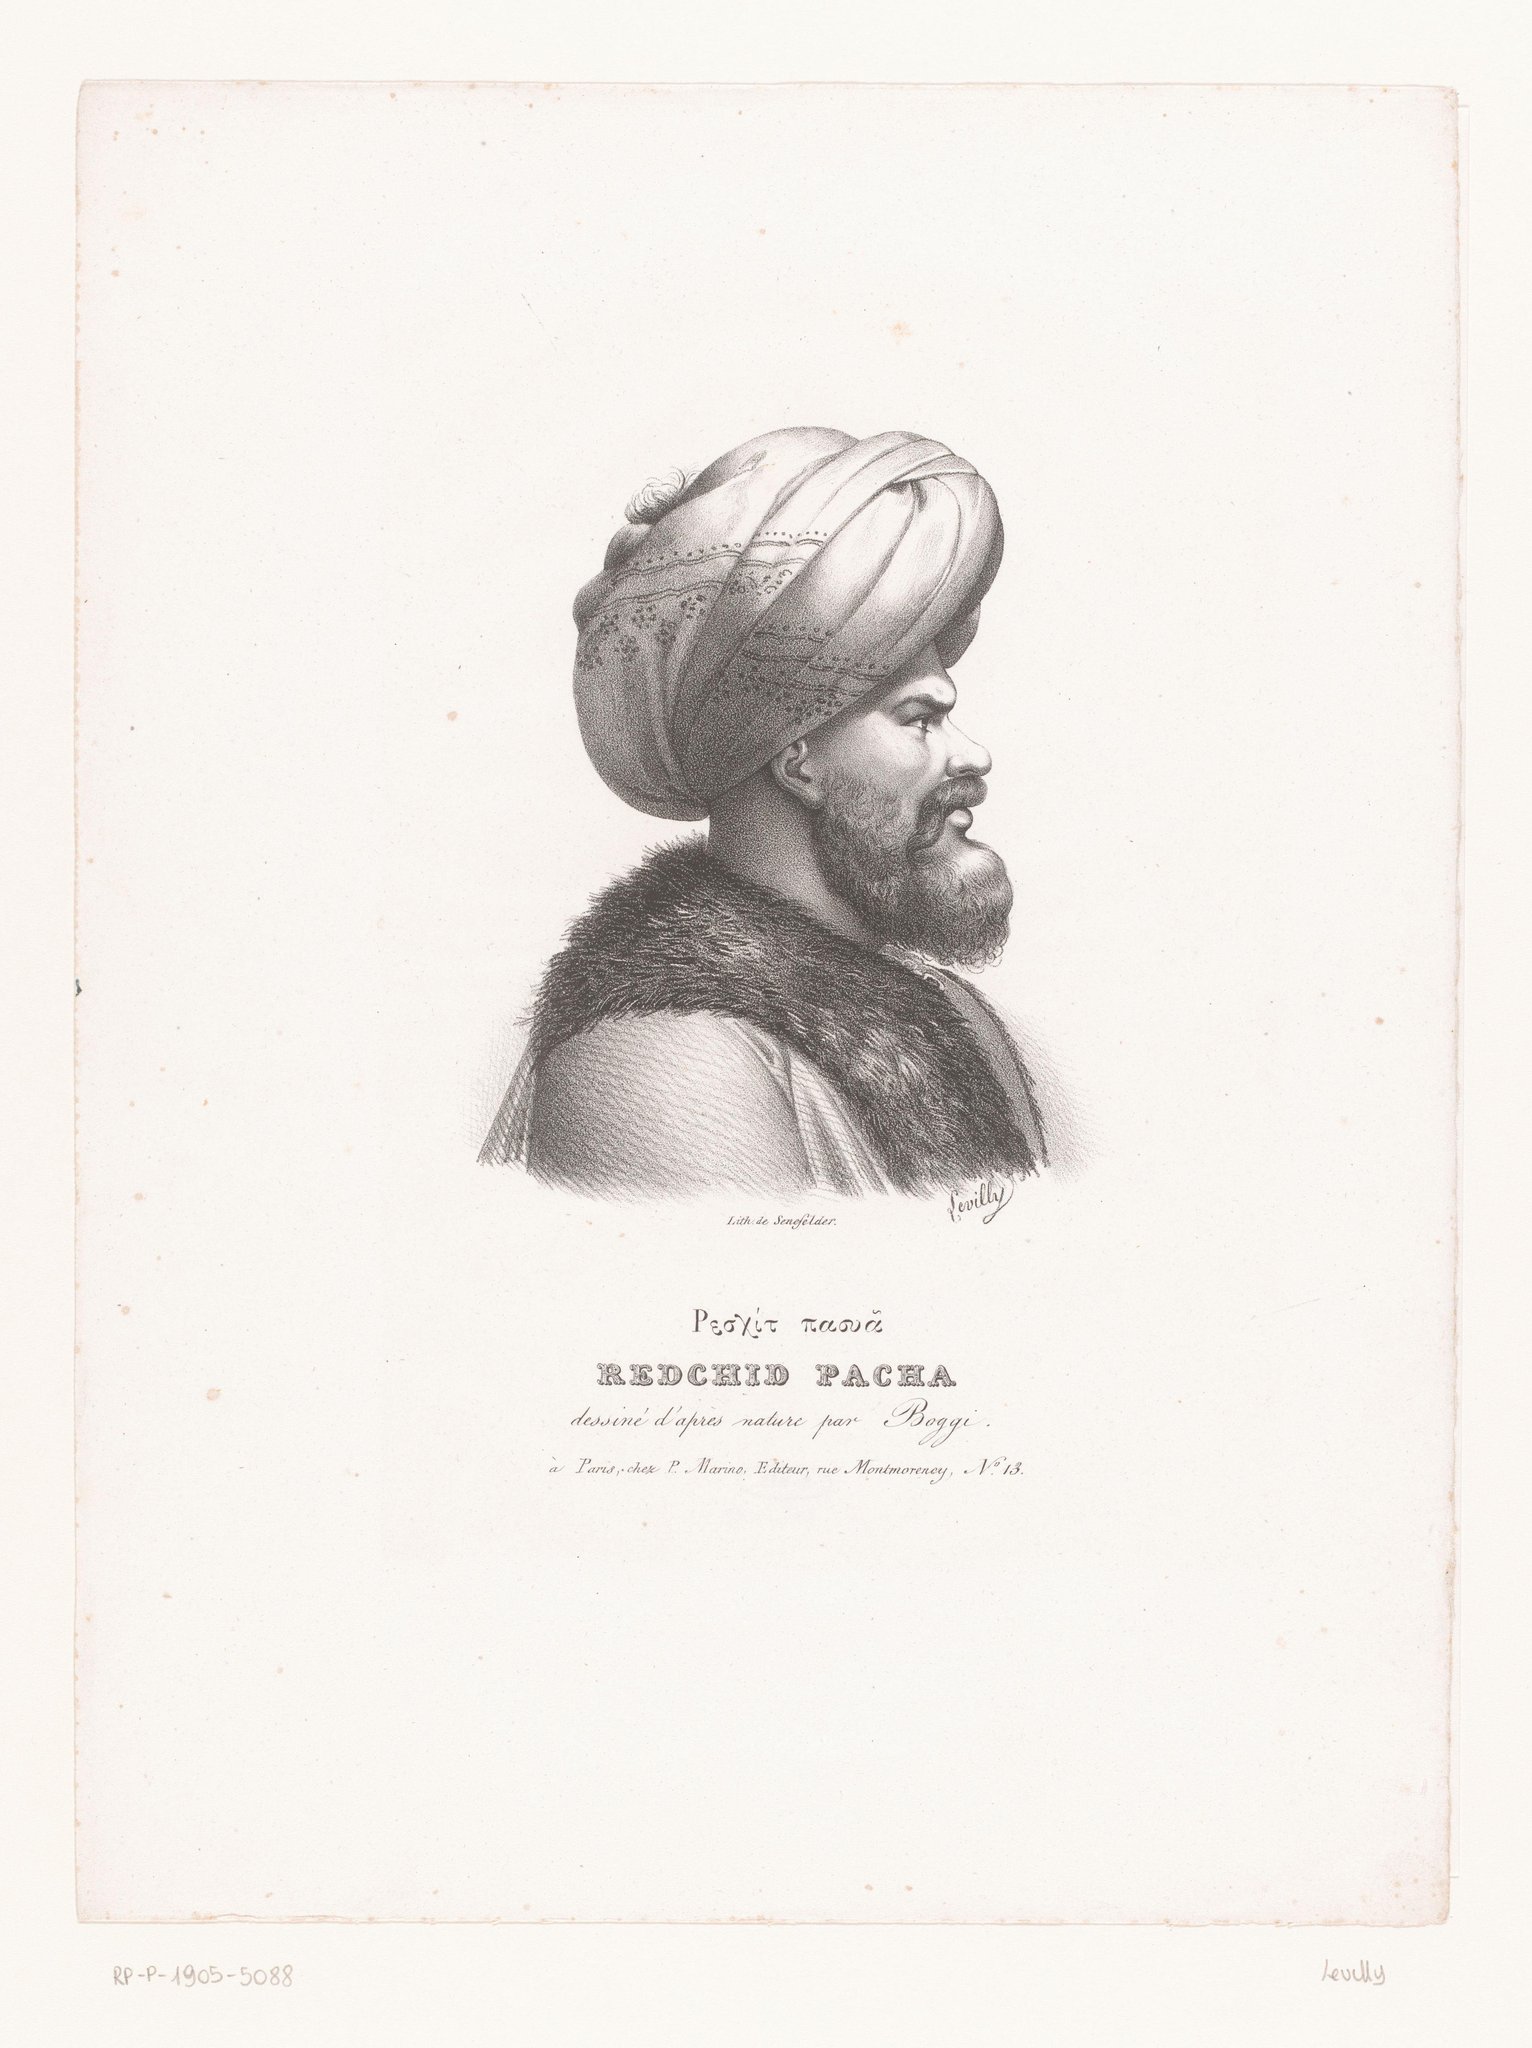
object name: print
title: Redchid Pacha, dessiné d'après nature par Boggi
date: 1827-1829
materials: paper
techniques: lithograph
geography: paris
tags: historical persons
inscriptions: collector's mark: Lugt 2228